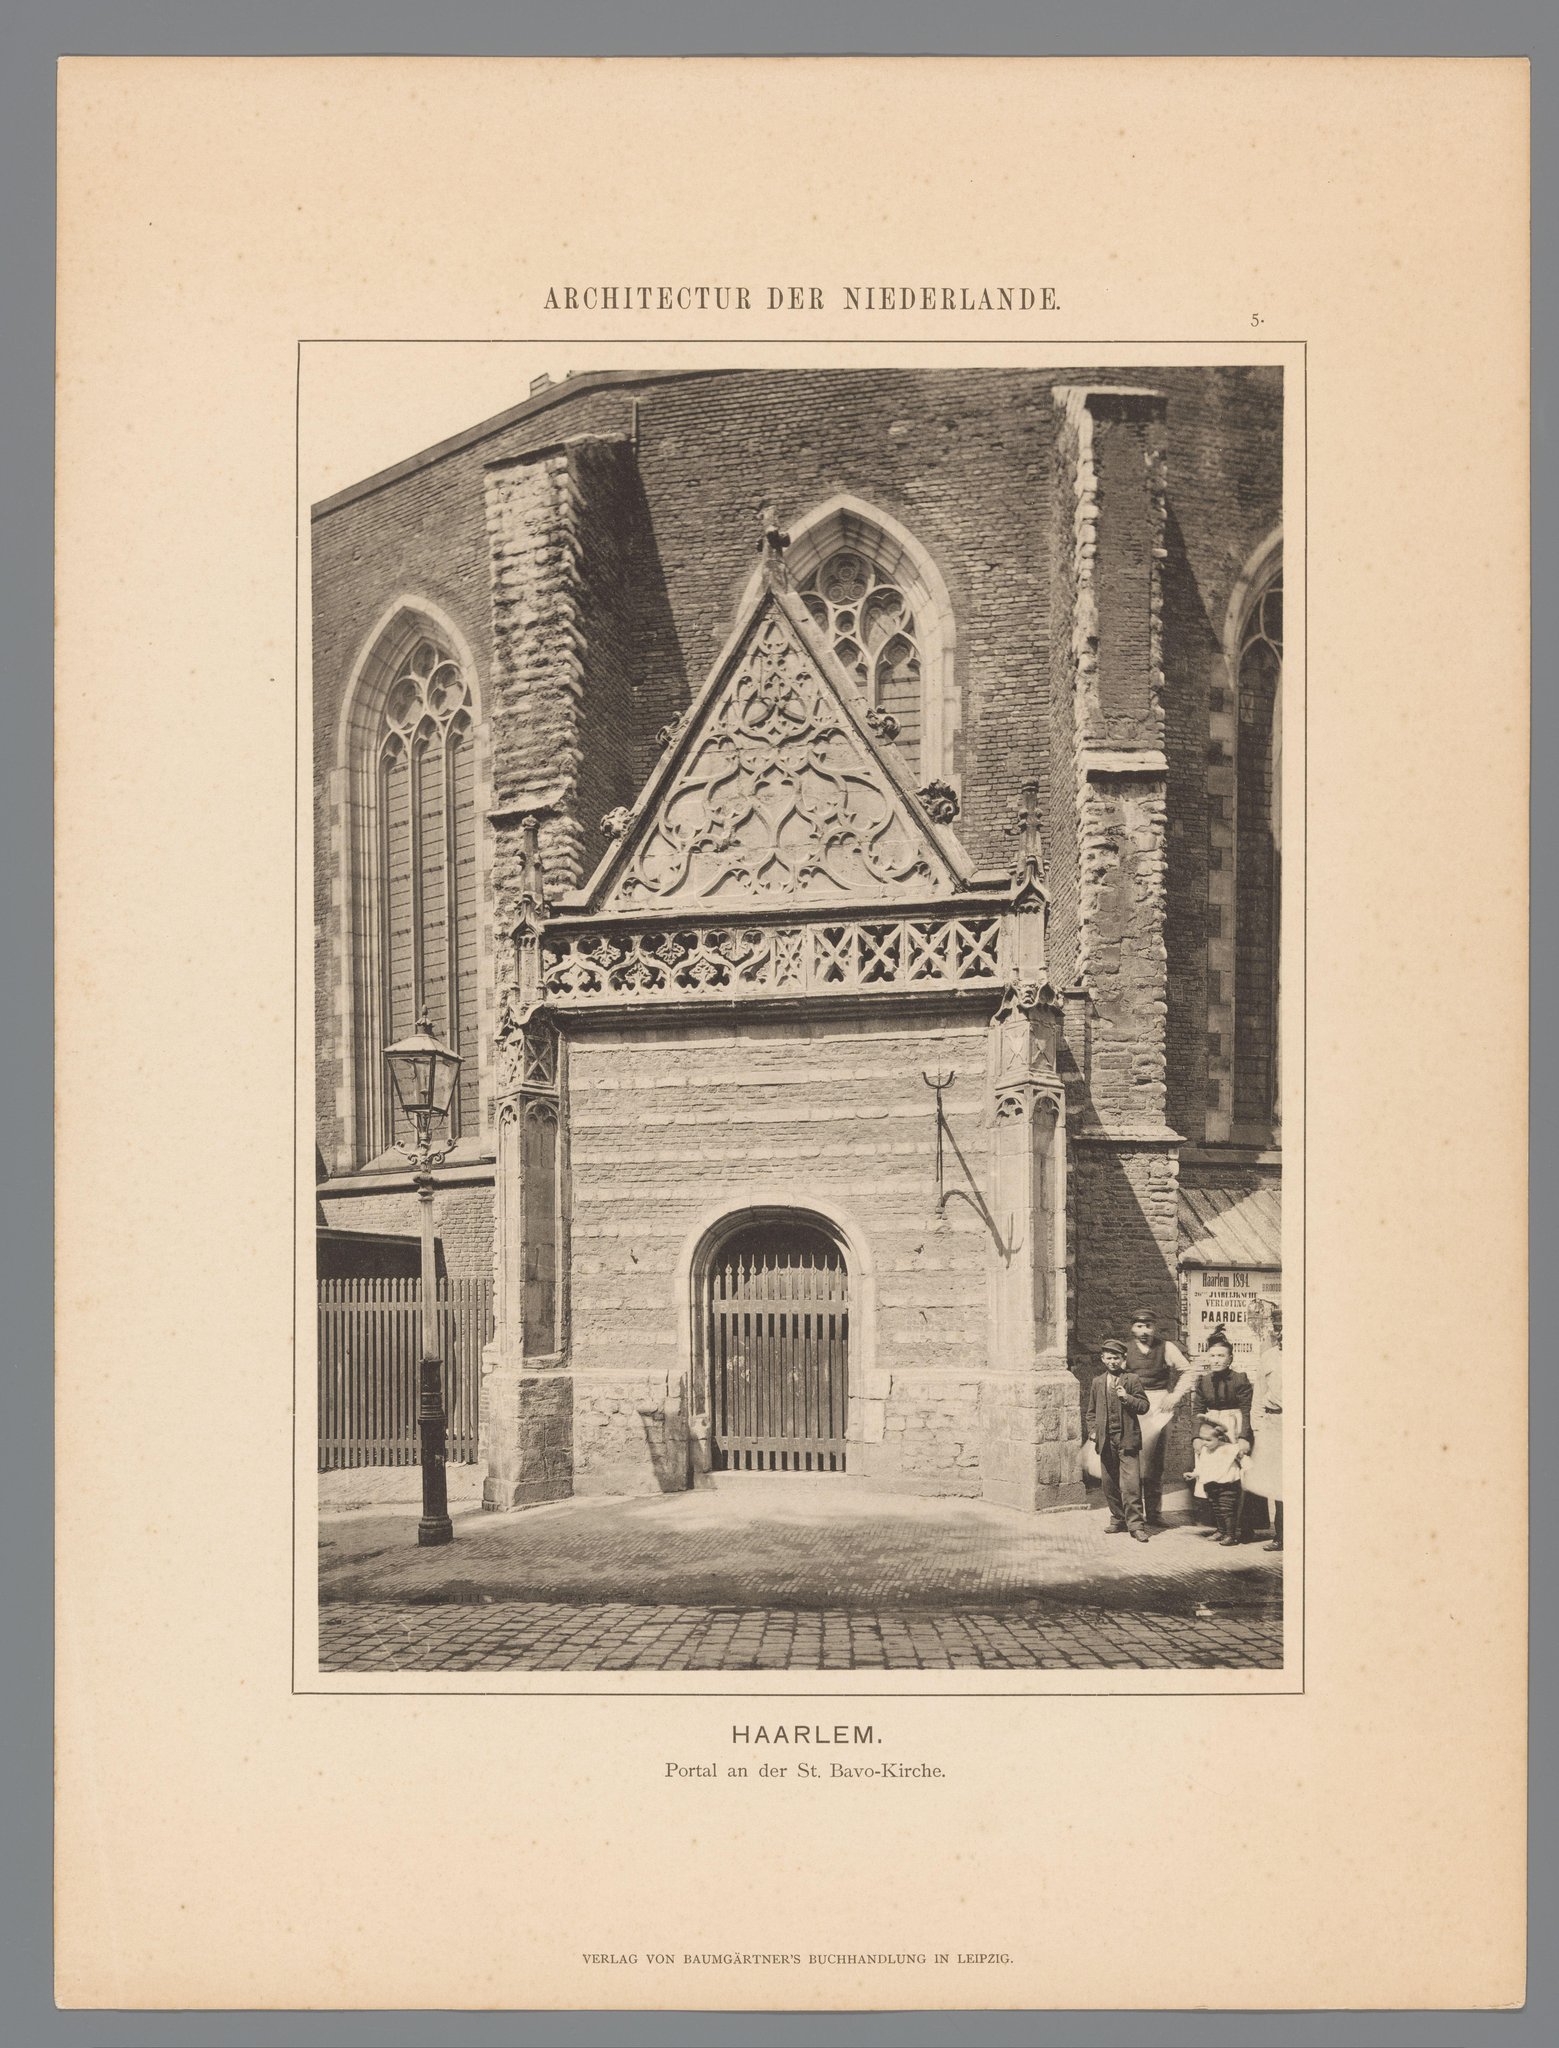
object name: photomechanical print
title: Architectuur in Nederland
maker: Anonymous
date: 1894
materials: paper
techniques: photograph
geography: leipzig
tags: parts of church exterior and annexes: portal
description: Afdruk uit: Krook, L. Architectur der Niederlande. Leipzig: Baumgärtner's Buchhandlung, 1894.